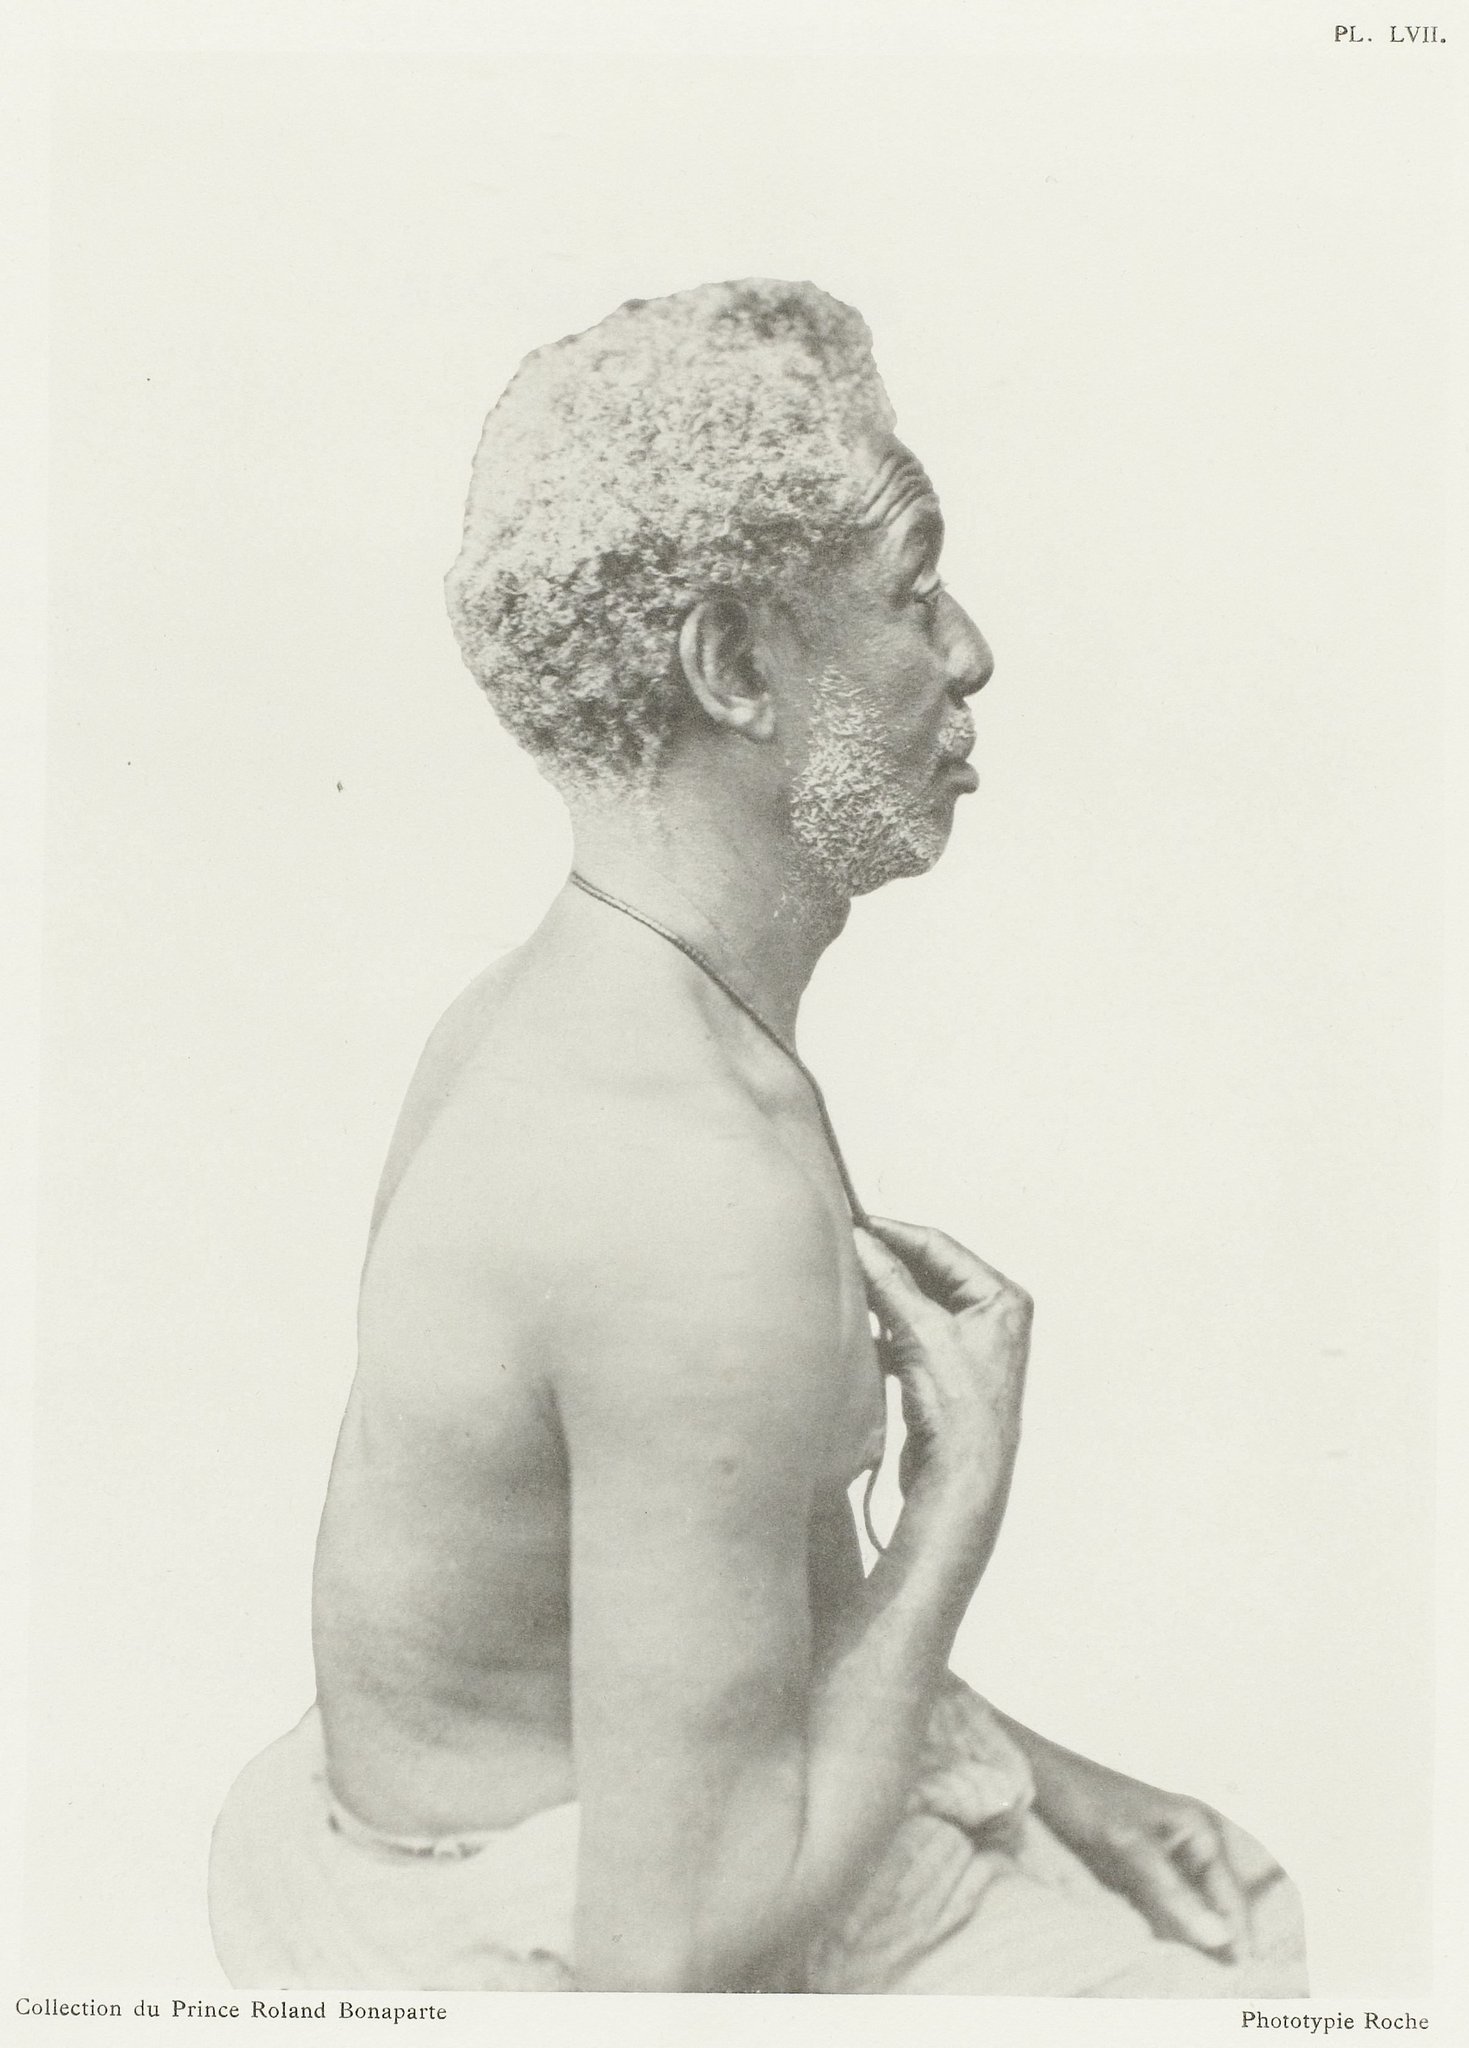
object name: photomechanical print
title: Portret van Syntax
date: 1883-1884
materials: paper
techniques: photograph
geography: amsterdam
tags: adult man, historical persons, amsterdam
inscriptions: inscription: ‘Collection du Prince Roland Bonaparte/ Phototypie Roche’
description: Portret van Syntax, een Surinaamse man van Afrikaanse oorsprong, gefotografeerd op de Internationale Koloniale en Uitvoerhandel Tentoonstelling, Amsterdam 1883.